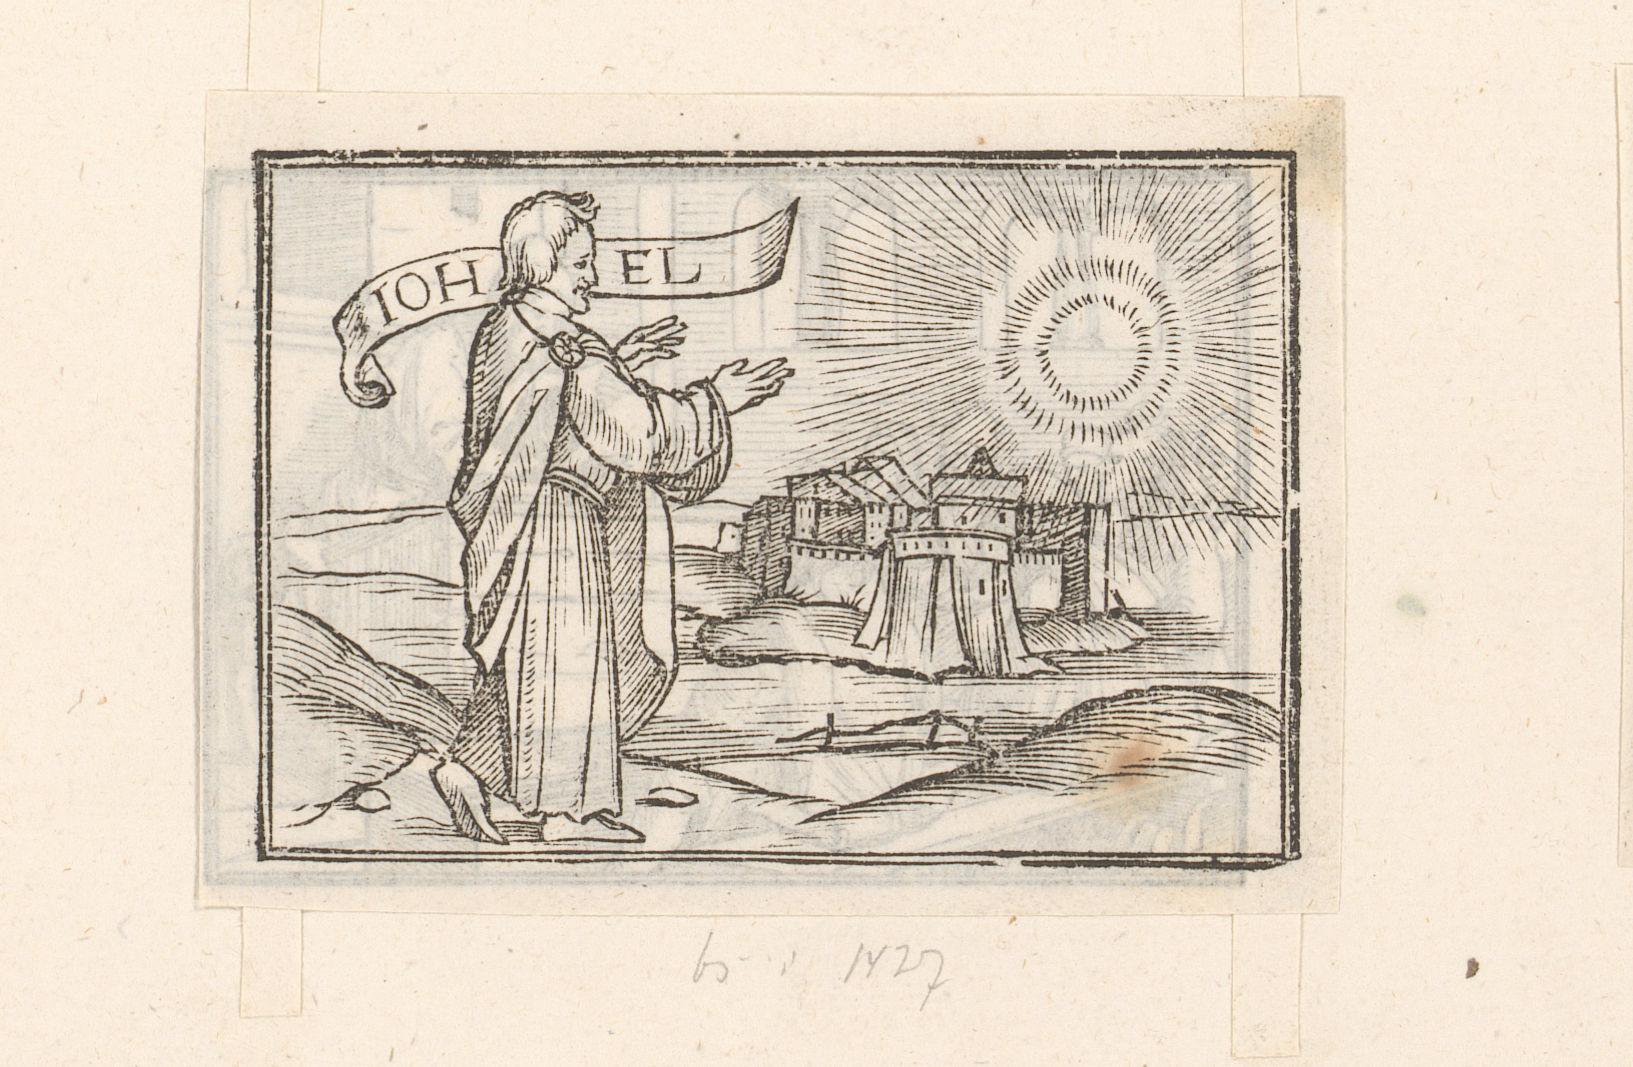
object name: book illustration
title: Profeet Joël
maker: veit rudolf specklin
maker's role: print maker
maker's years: -1550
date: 1538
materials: paper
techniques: woodcut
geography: switzerland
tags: joel's prophecies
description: Boekillustratie voor het eerst gebruikt in: Biblia Utriusque Testamenti iuxta Vulgatam Translationem, Lyon, M. en G. Trechsel (voor Hugo à Porta) 1538. Later in verschillende uitgaven opnieuw gebruikt. Deze prent vermoedelijk gebruikt in één van de uitgaven uitgegeven en/of gedrukt door Jean Frellon, Lyon.